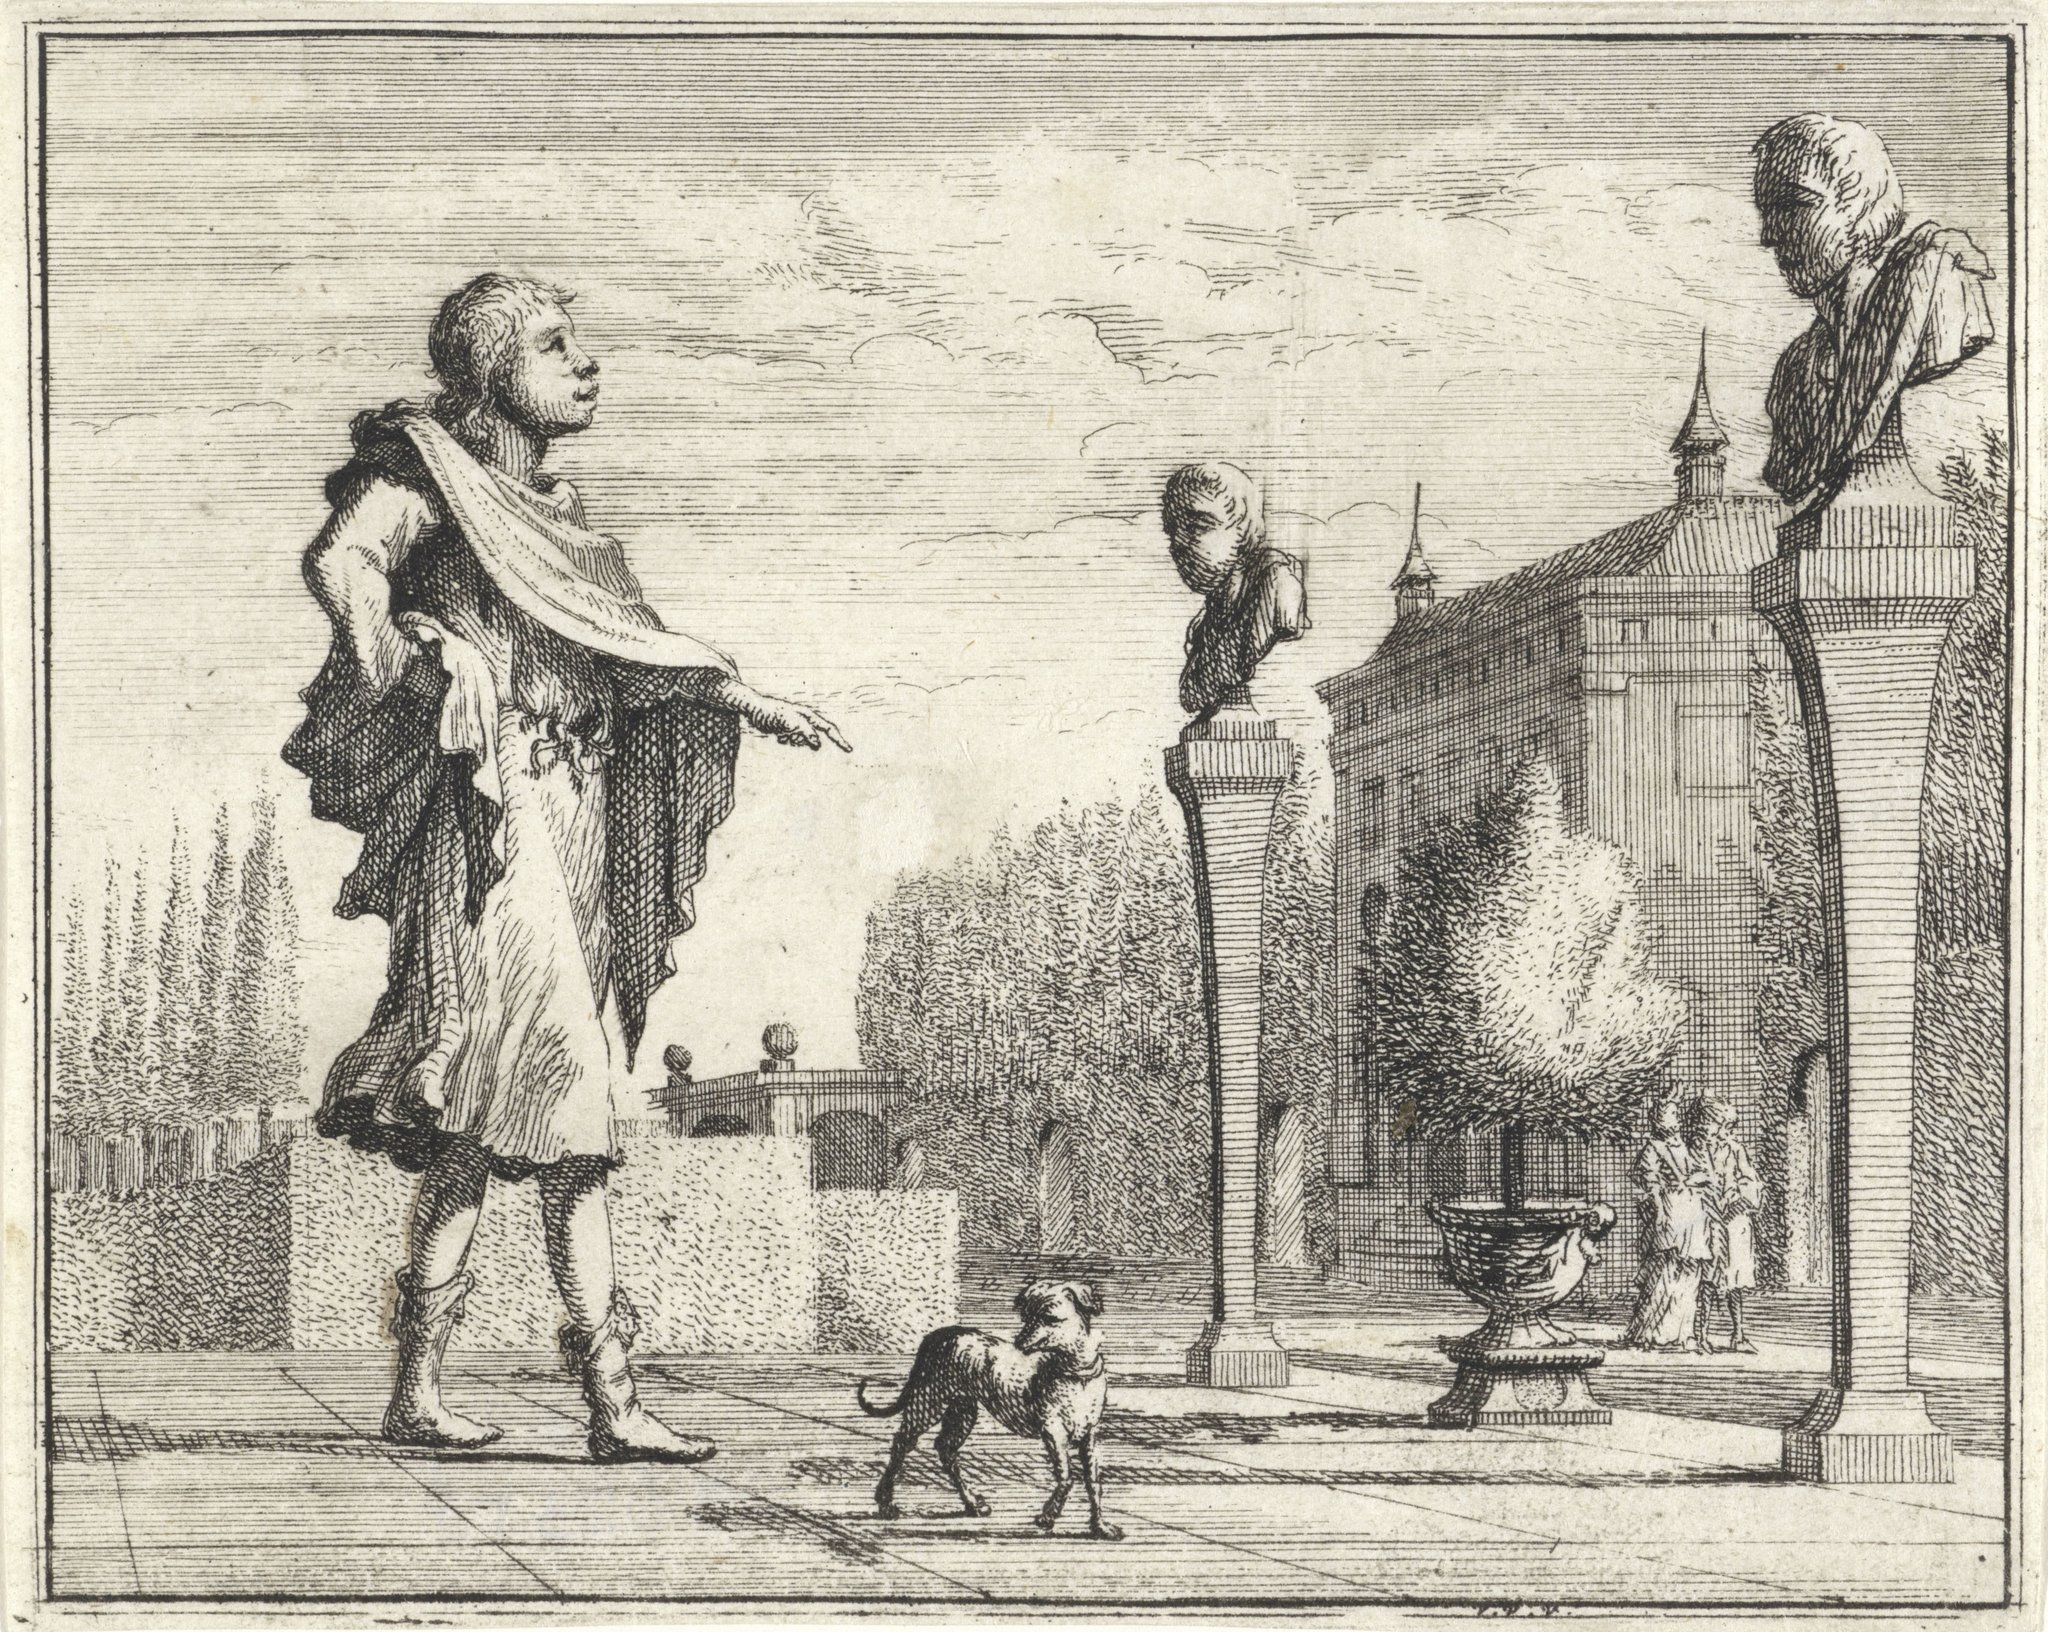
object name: print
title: Man bij twee hermen in formele tuin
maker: vincent laurensz. van der vinne (ii)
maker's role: draughtsman, print maker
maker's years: 1686-1742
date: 1714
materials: paper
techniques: etching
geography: haarlem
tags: herms (garden ornaments), french or architectonic garden; formal garden, statues, sculptures in garden, dog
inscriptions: collector's mark: Lugt 2228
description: Een man staat bij twee hermen en een boom in een pot in een tuin van een landhuis. Naast hem een hond en op de achtergrond een wandelend paar. Zinnebeeld op de vergankelijkheid van de aardse wereld.